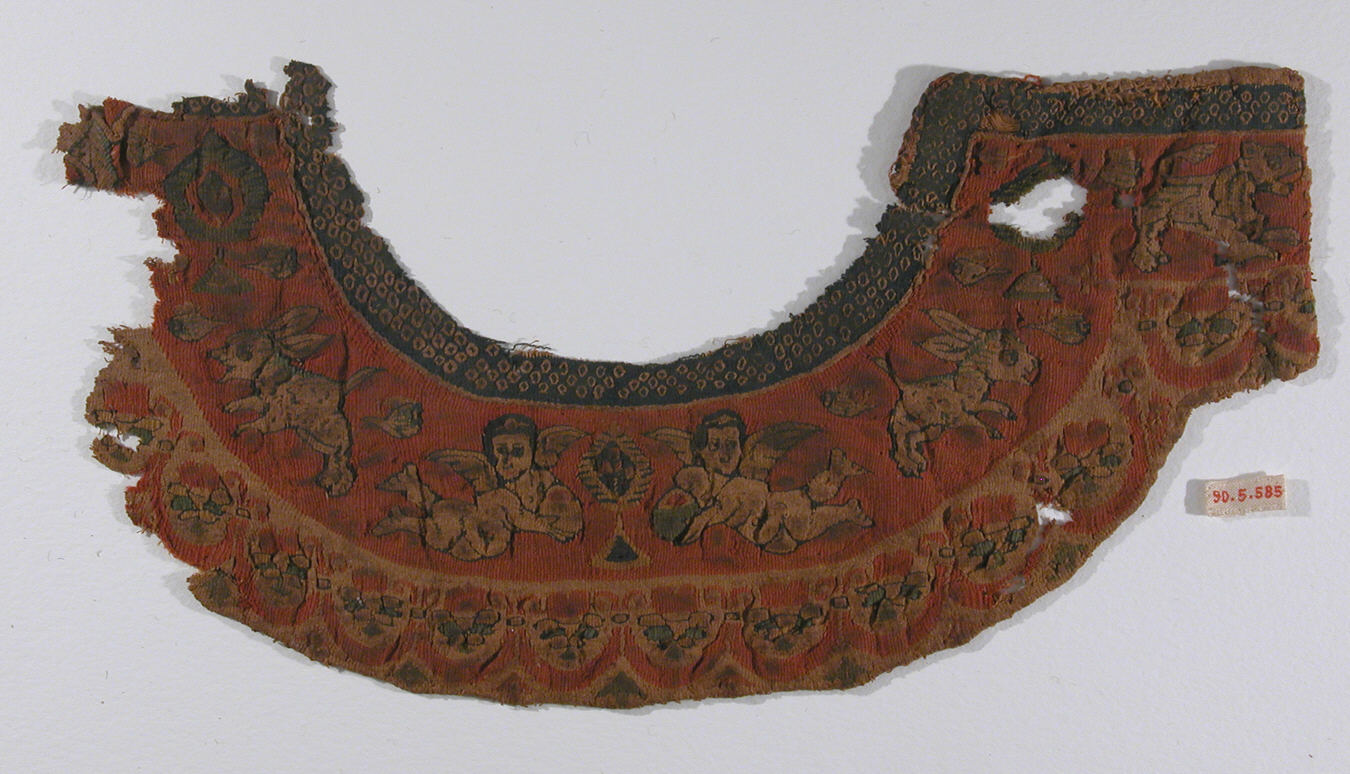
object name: textile fragment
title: Neck Band from a Tunic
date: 401-800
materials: linen, wool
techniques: weave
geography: egypt